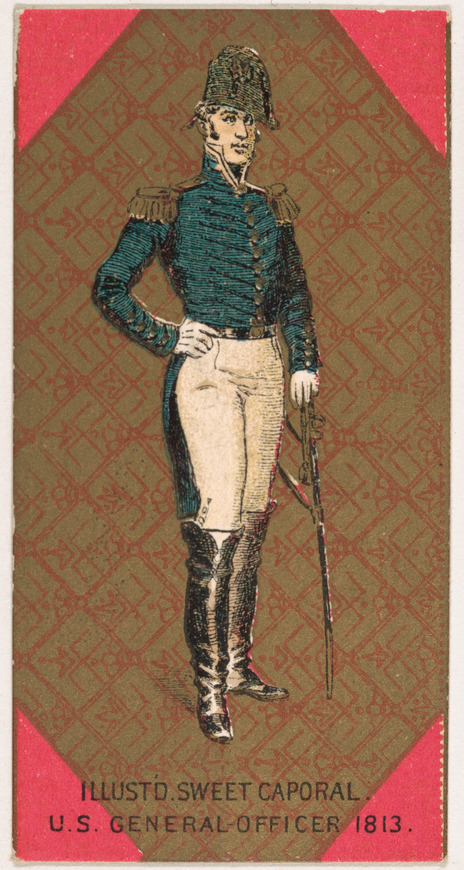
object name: print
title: General Officer, United States Army, 1813, from the Military Series (N224) issued by Kinney Tobacco Company to promote Sweet Caporal Cigarettes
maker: kinney brothers tobacco company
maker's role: publisher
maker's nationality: american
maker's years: 1869-2011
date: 1888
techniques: color lithograph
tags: military,men